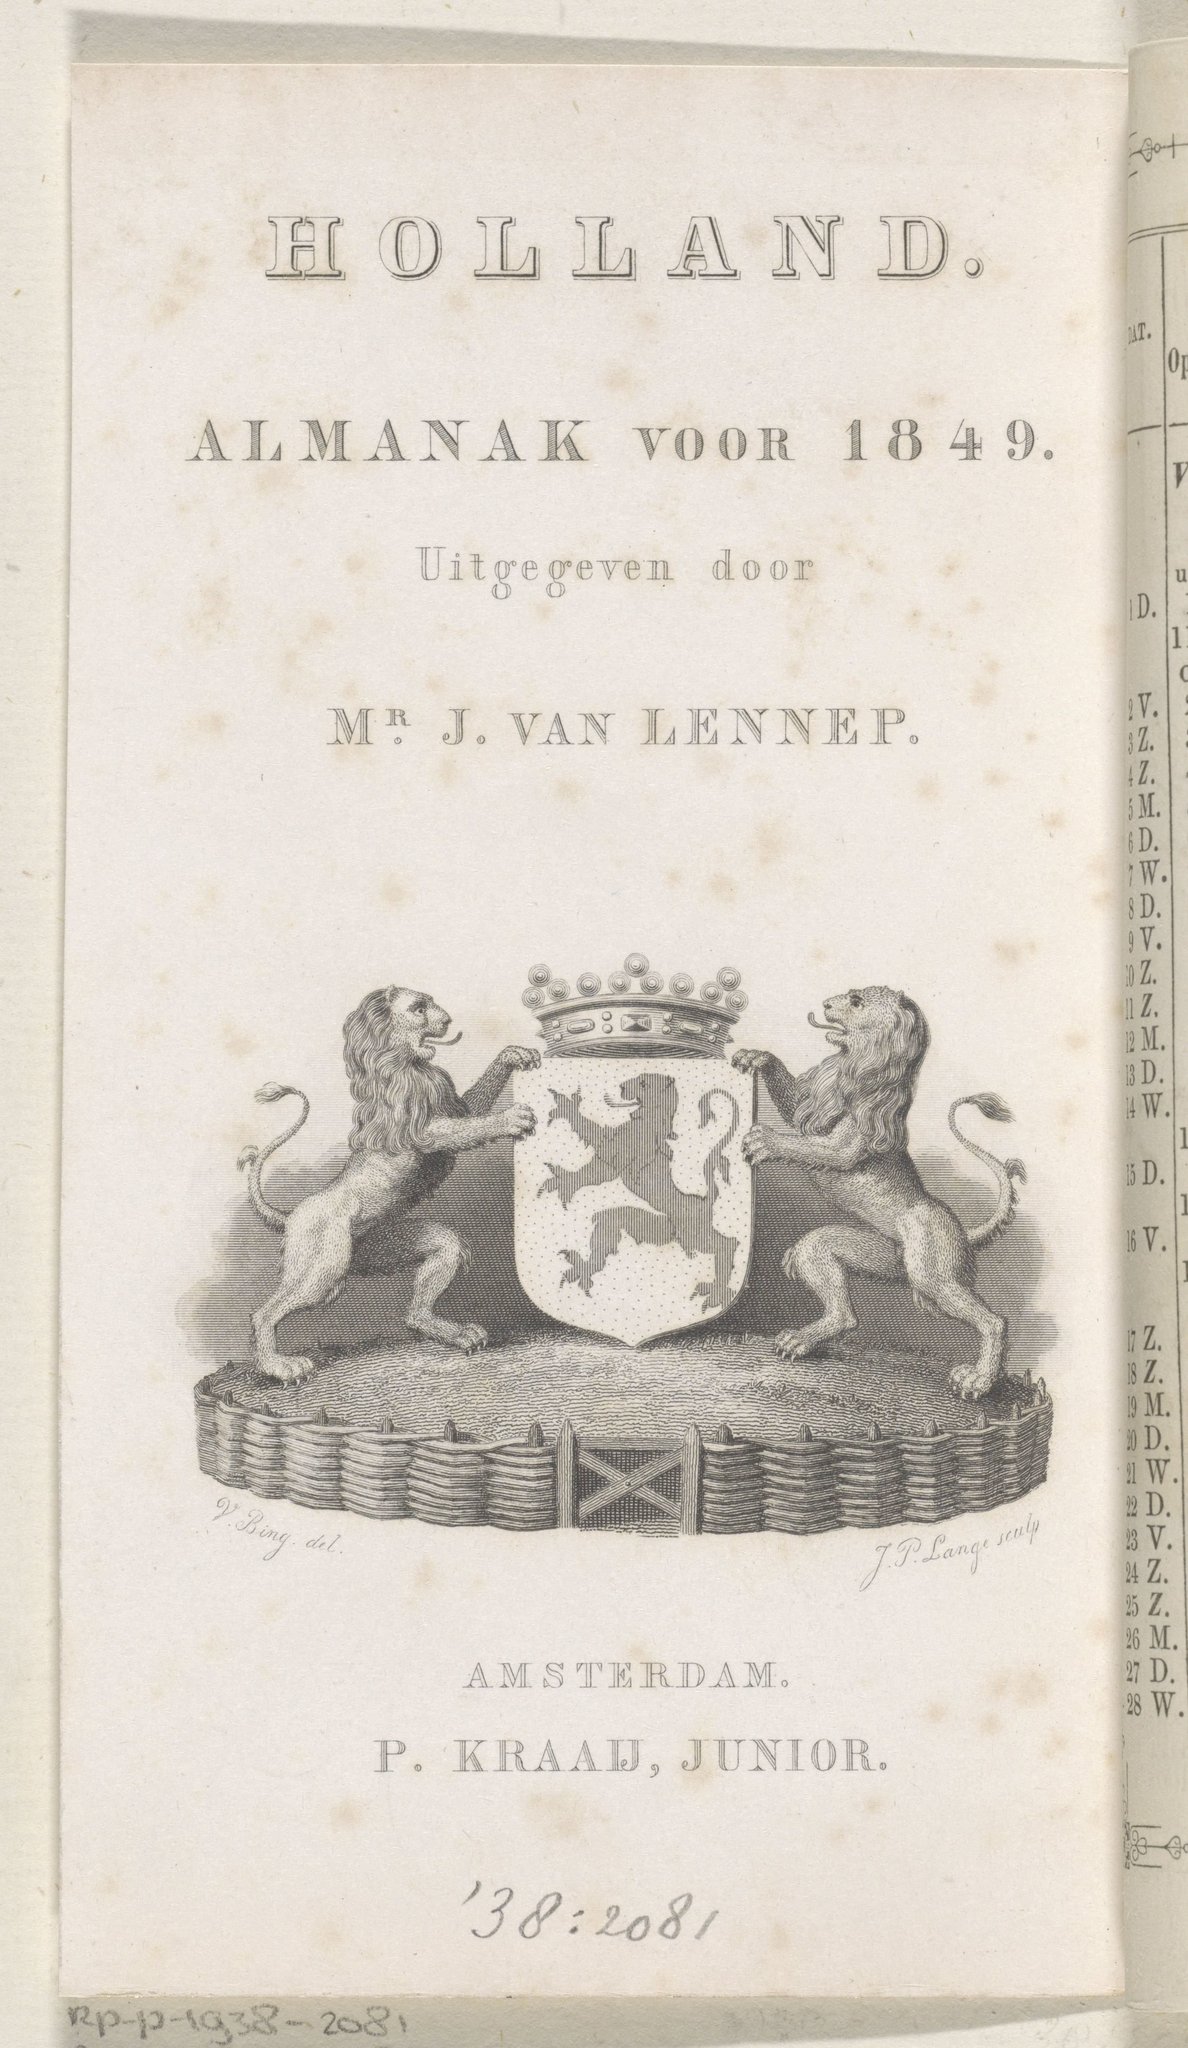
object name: titelblad, titelpagina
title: Titelpagina voor: Jacob van Lennep, Holland. Almanak voor 1849, 1849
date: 1849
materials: paper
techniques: engraving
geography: amsterdam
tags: holland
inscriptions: collector's mark: Lugt 2760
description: Titelpagina voor: Lennep, Jacob van. Holland. Almanak voor 1849. Amsterdam: P. Kraaij (Jr.), 1849.